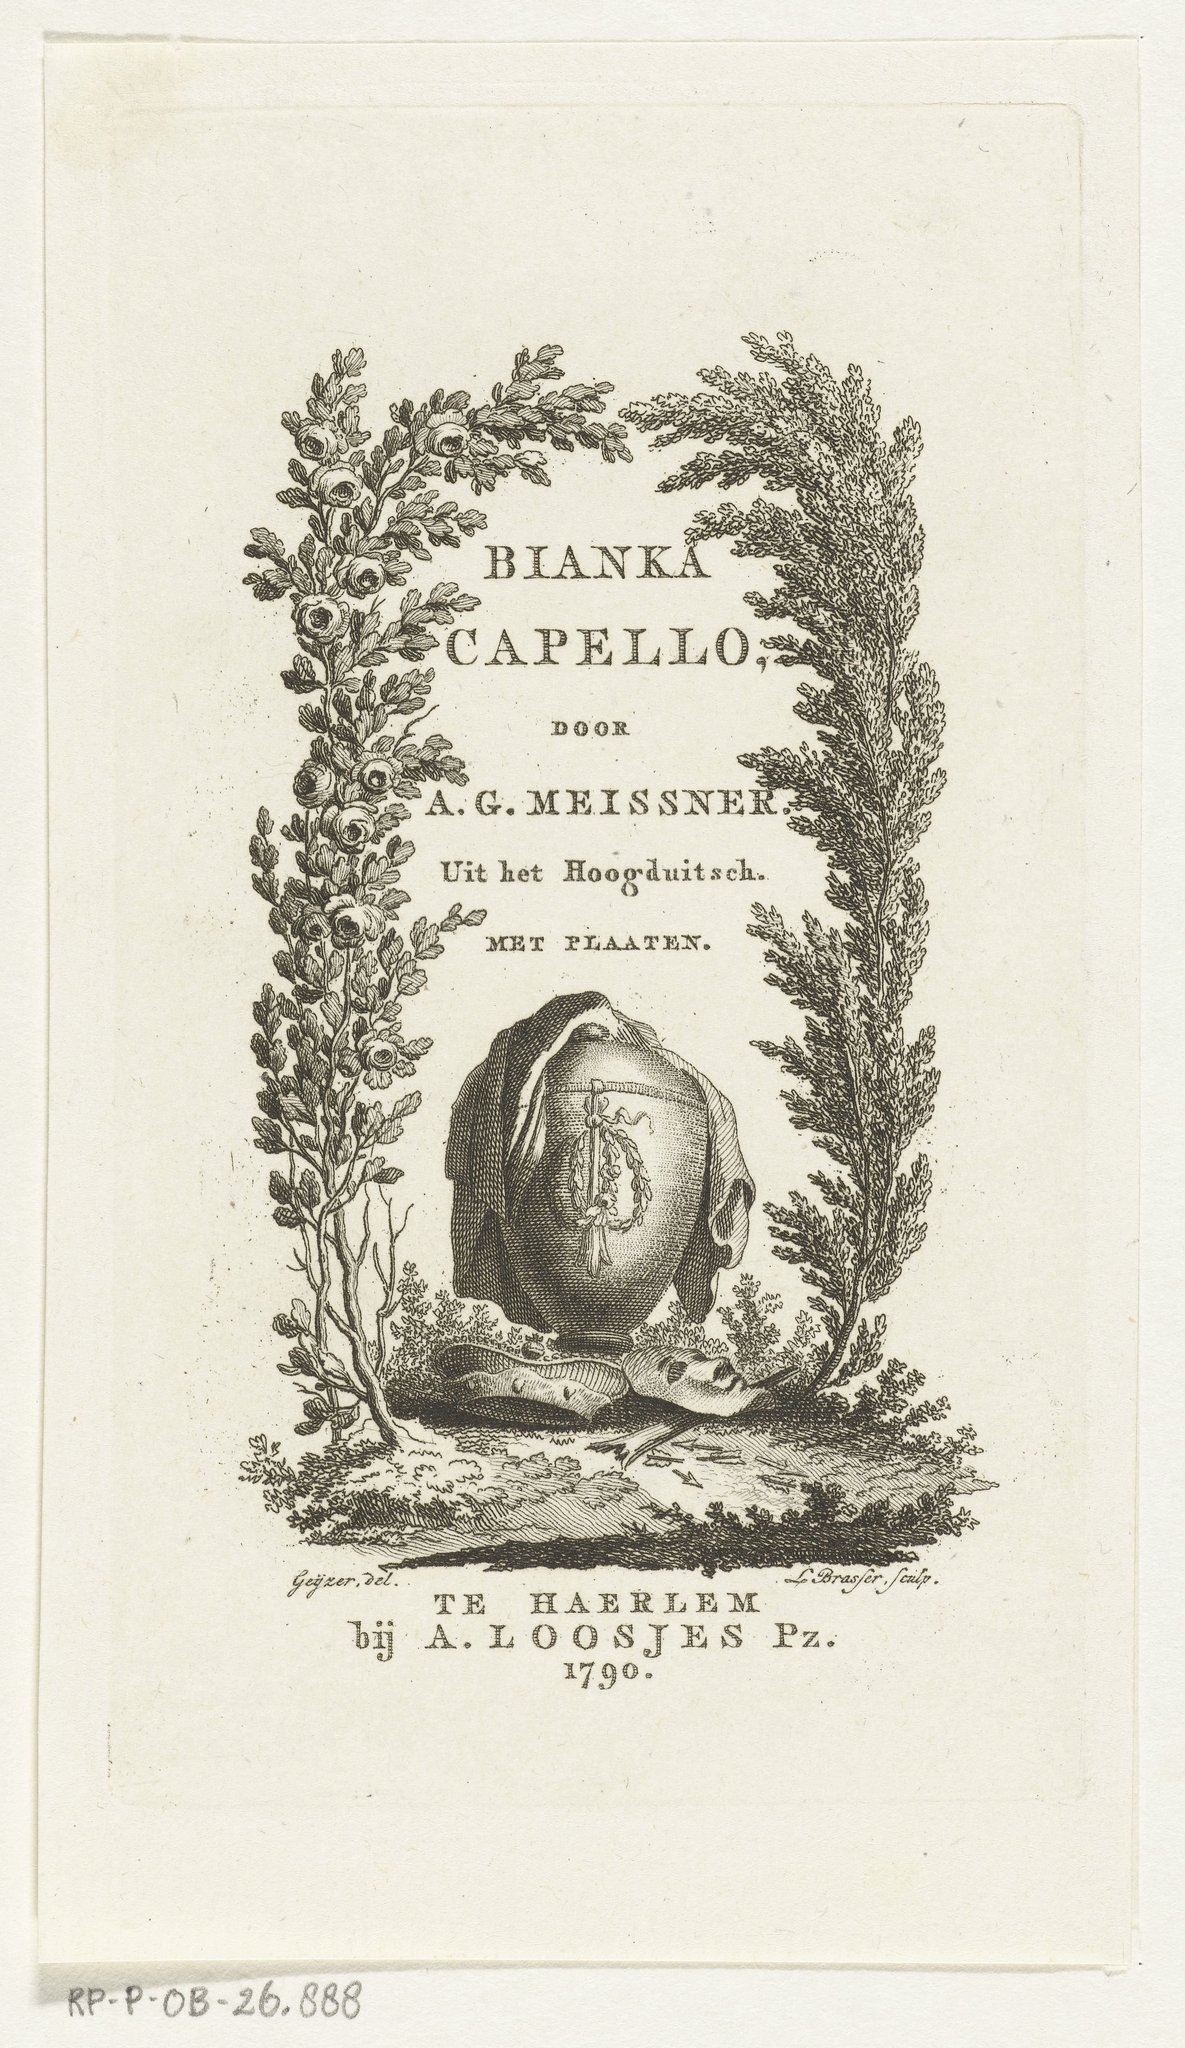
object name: print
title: Titel omlijst door rozenstruik, vaas en Venetiaans masker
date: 1785-1790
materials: paper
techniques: engraving, etching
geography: haarlem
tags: mask, shrubs: rose-bush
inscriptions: collector's mark: Lugt 2228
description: Titel omlijst door onder andere rozenstruik, vaas en een Venetiaans masker als verwijzing naar de hoofdpersoon in de roman van Meissner: Bianca Capello.